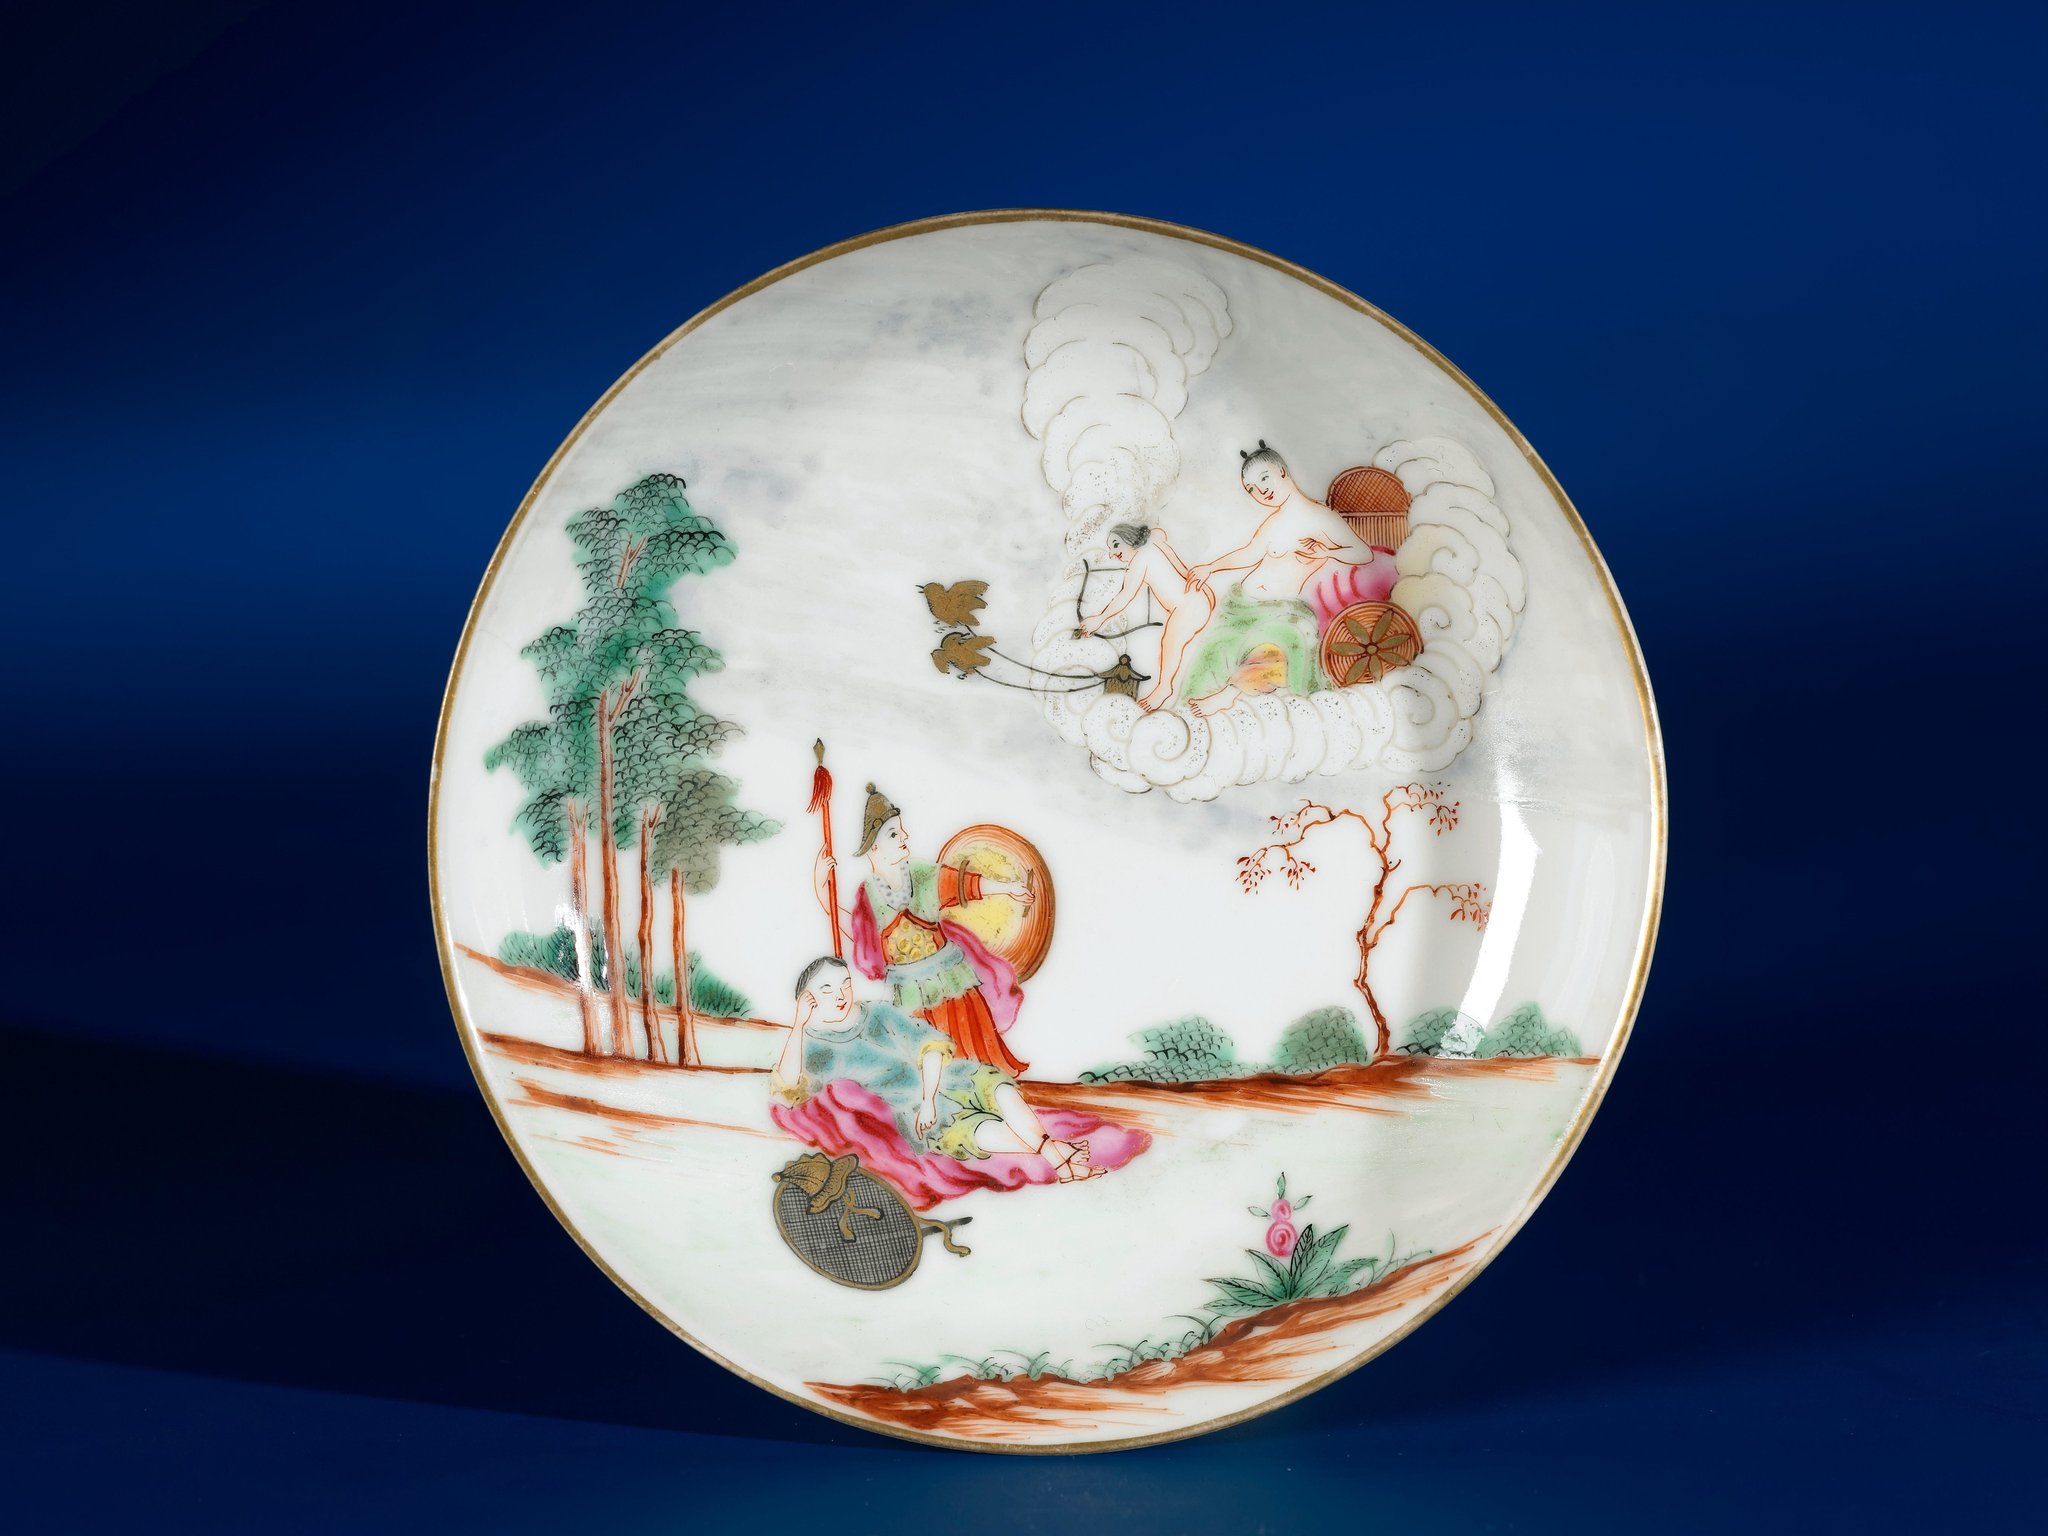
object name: platter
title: Saucer with a mythological scene with Venus, Cupid and Minerva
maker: Anonymous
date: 1740-1760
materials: glaze, gold, paint, porcelain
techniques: firing, gilding, turning, vitrification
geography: china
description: Schotel van porselein, beschilderd op het glazuur in blauw, rood, roze, groen, geel, zwart en goud. Op de voorzijde in de wolken is Venus afgebeeld, gezeten in een wagen die wordt getrokken door twee duiven. Voor haar staat Cupido, die zijn pijlen naar beneden richt. Beneden staat Minerva, beschermster van de kunsten, wetenschappen, handwerk en krijgsgodin. Met een schild en een lans in haar handen beschermt zij een soldaat, slapend in een landschap, tegen de pijlen van Cupido. Europese voorstelling in emailkleuren.